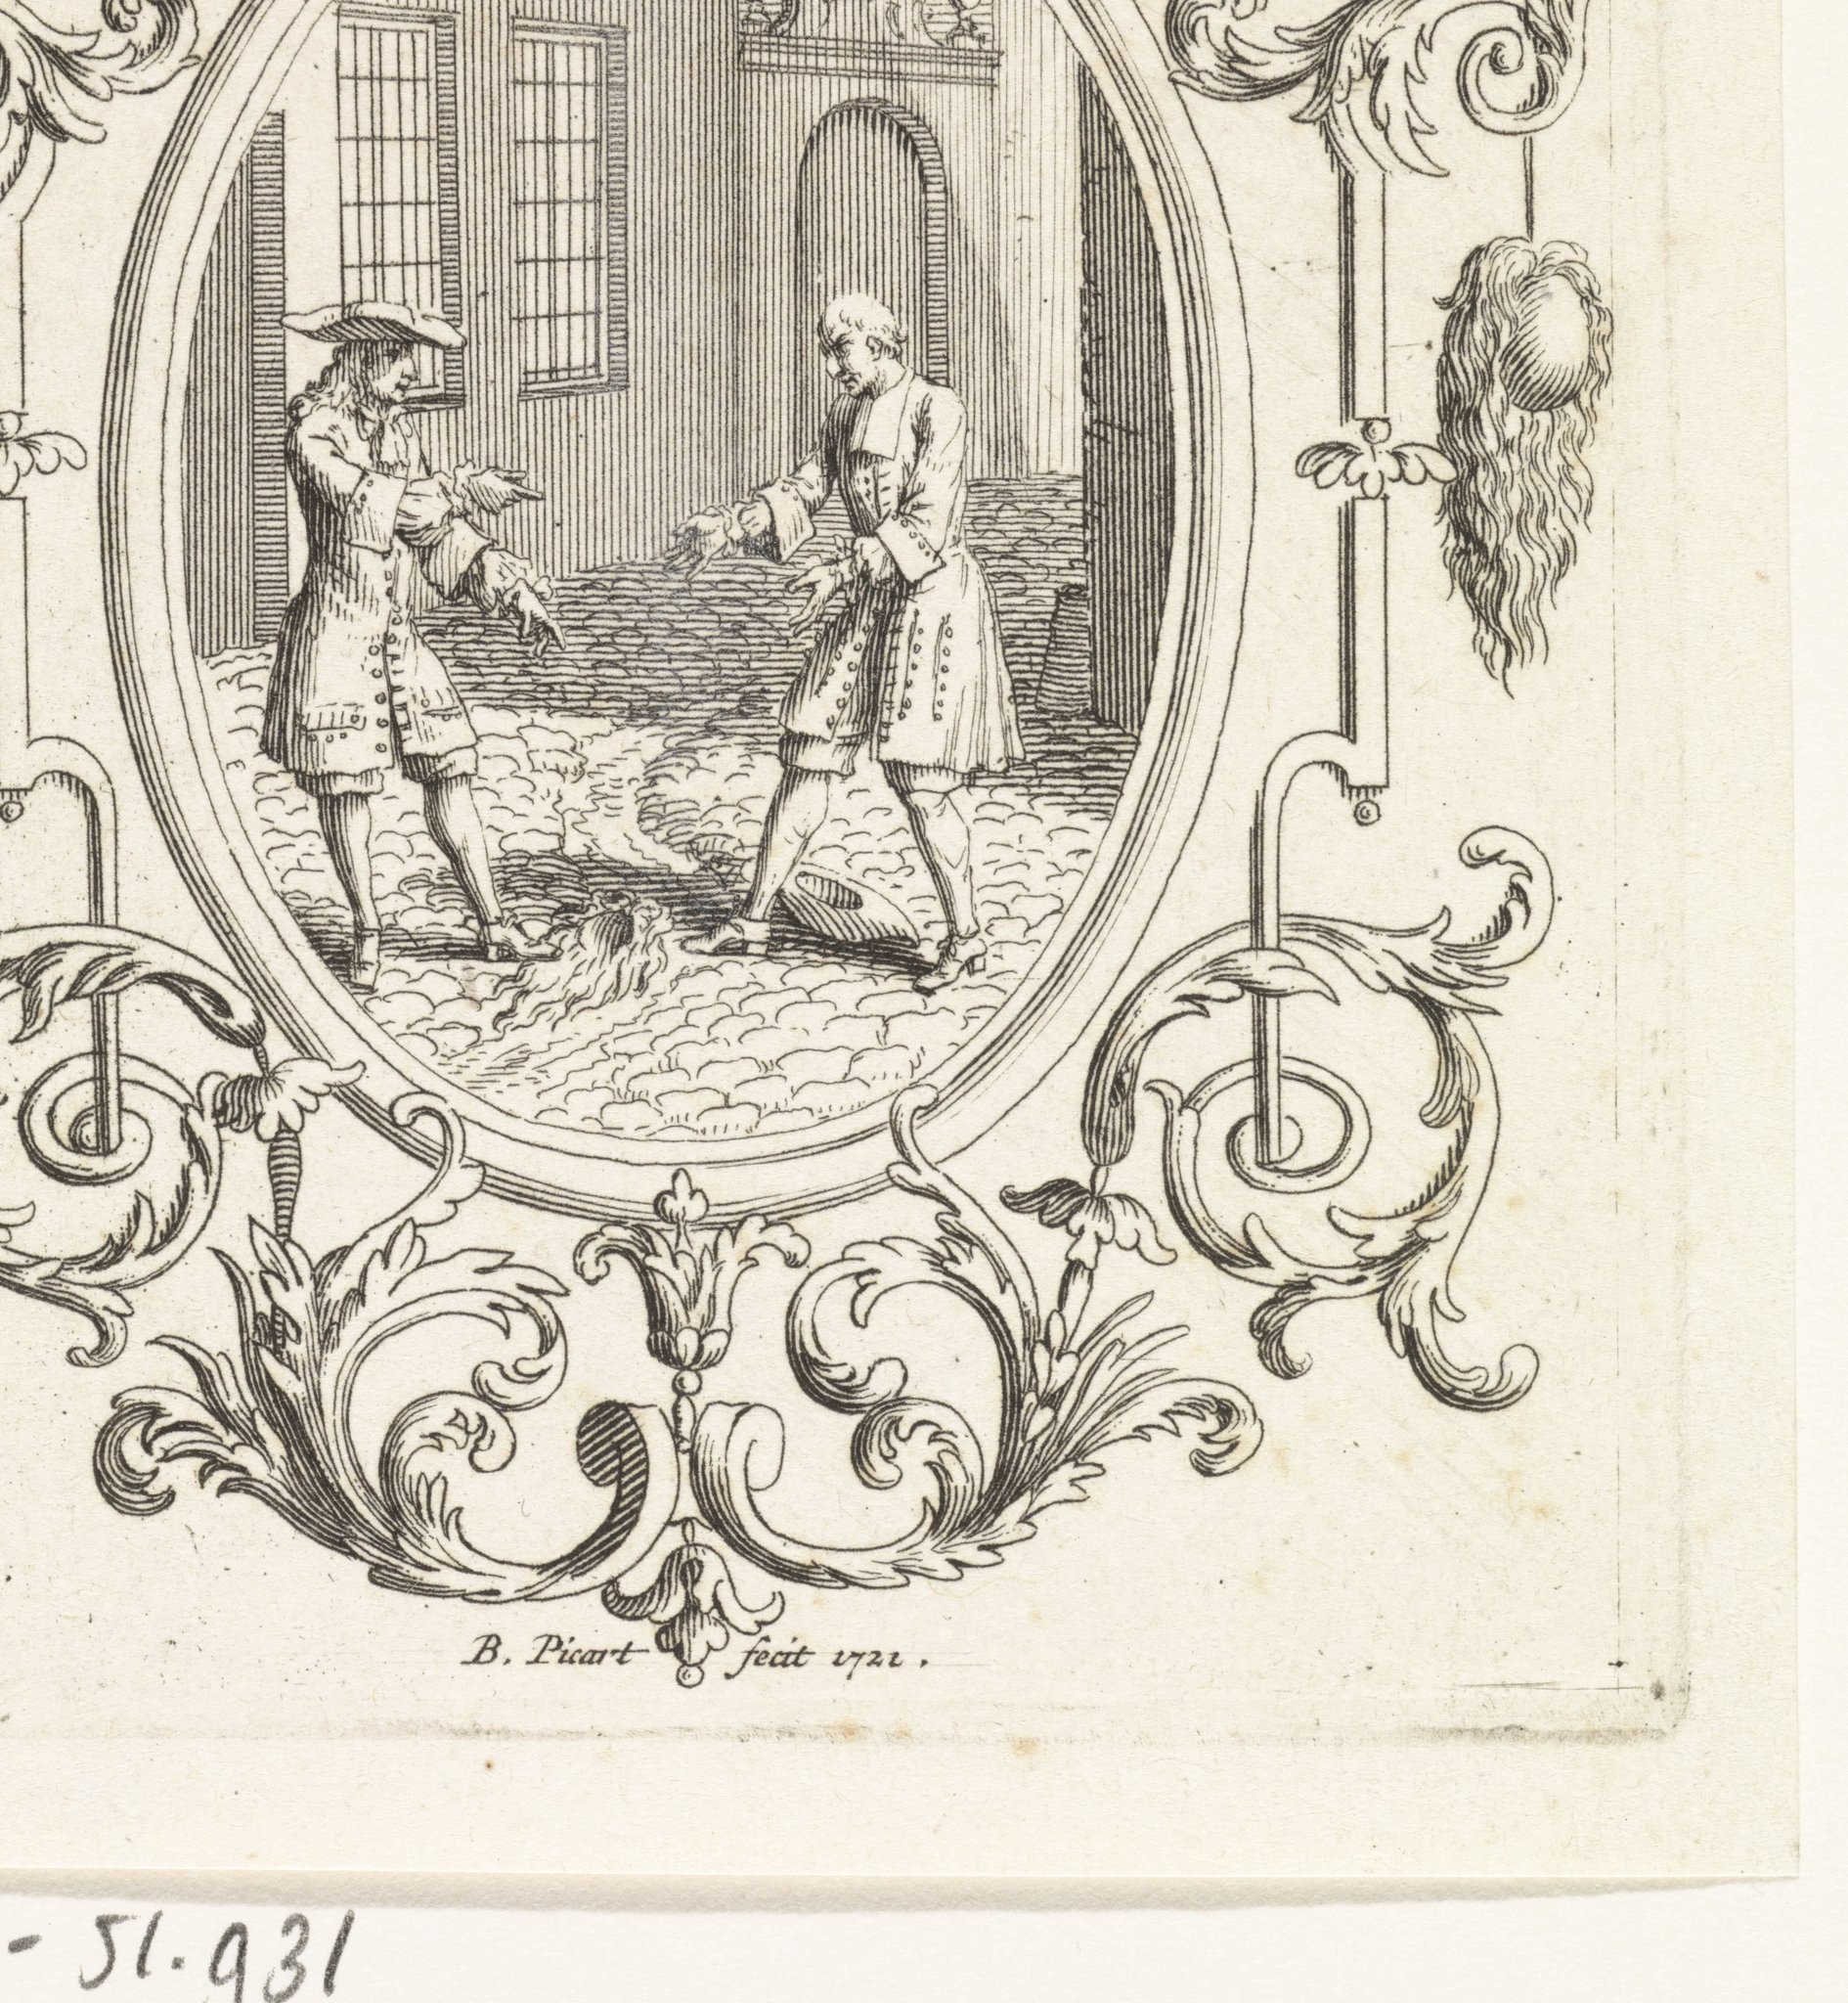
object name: print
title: Twee mannen bij een afgewaaide pruik en hoed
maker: bernard picart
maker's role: draughtsman, print maker, publisher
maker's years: 1673-1733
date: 1721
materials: paper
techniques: engraving, etching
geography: amsterdam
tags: scrollwork, strapwork ~ ornament, wig, foliage, tendrils, branches ~ ornament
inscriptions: collector's mark: Lugt 2228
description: Ovale voorstelling van twee mannen met elkaar in gesprek. Een van de mannen heeft zijn pruik en hoed verloren. De voorstelling is gevat in ee ornamentele omlijsting.